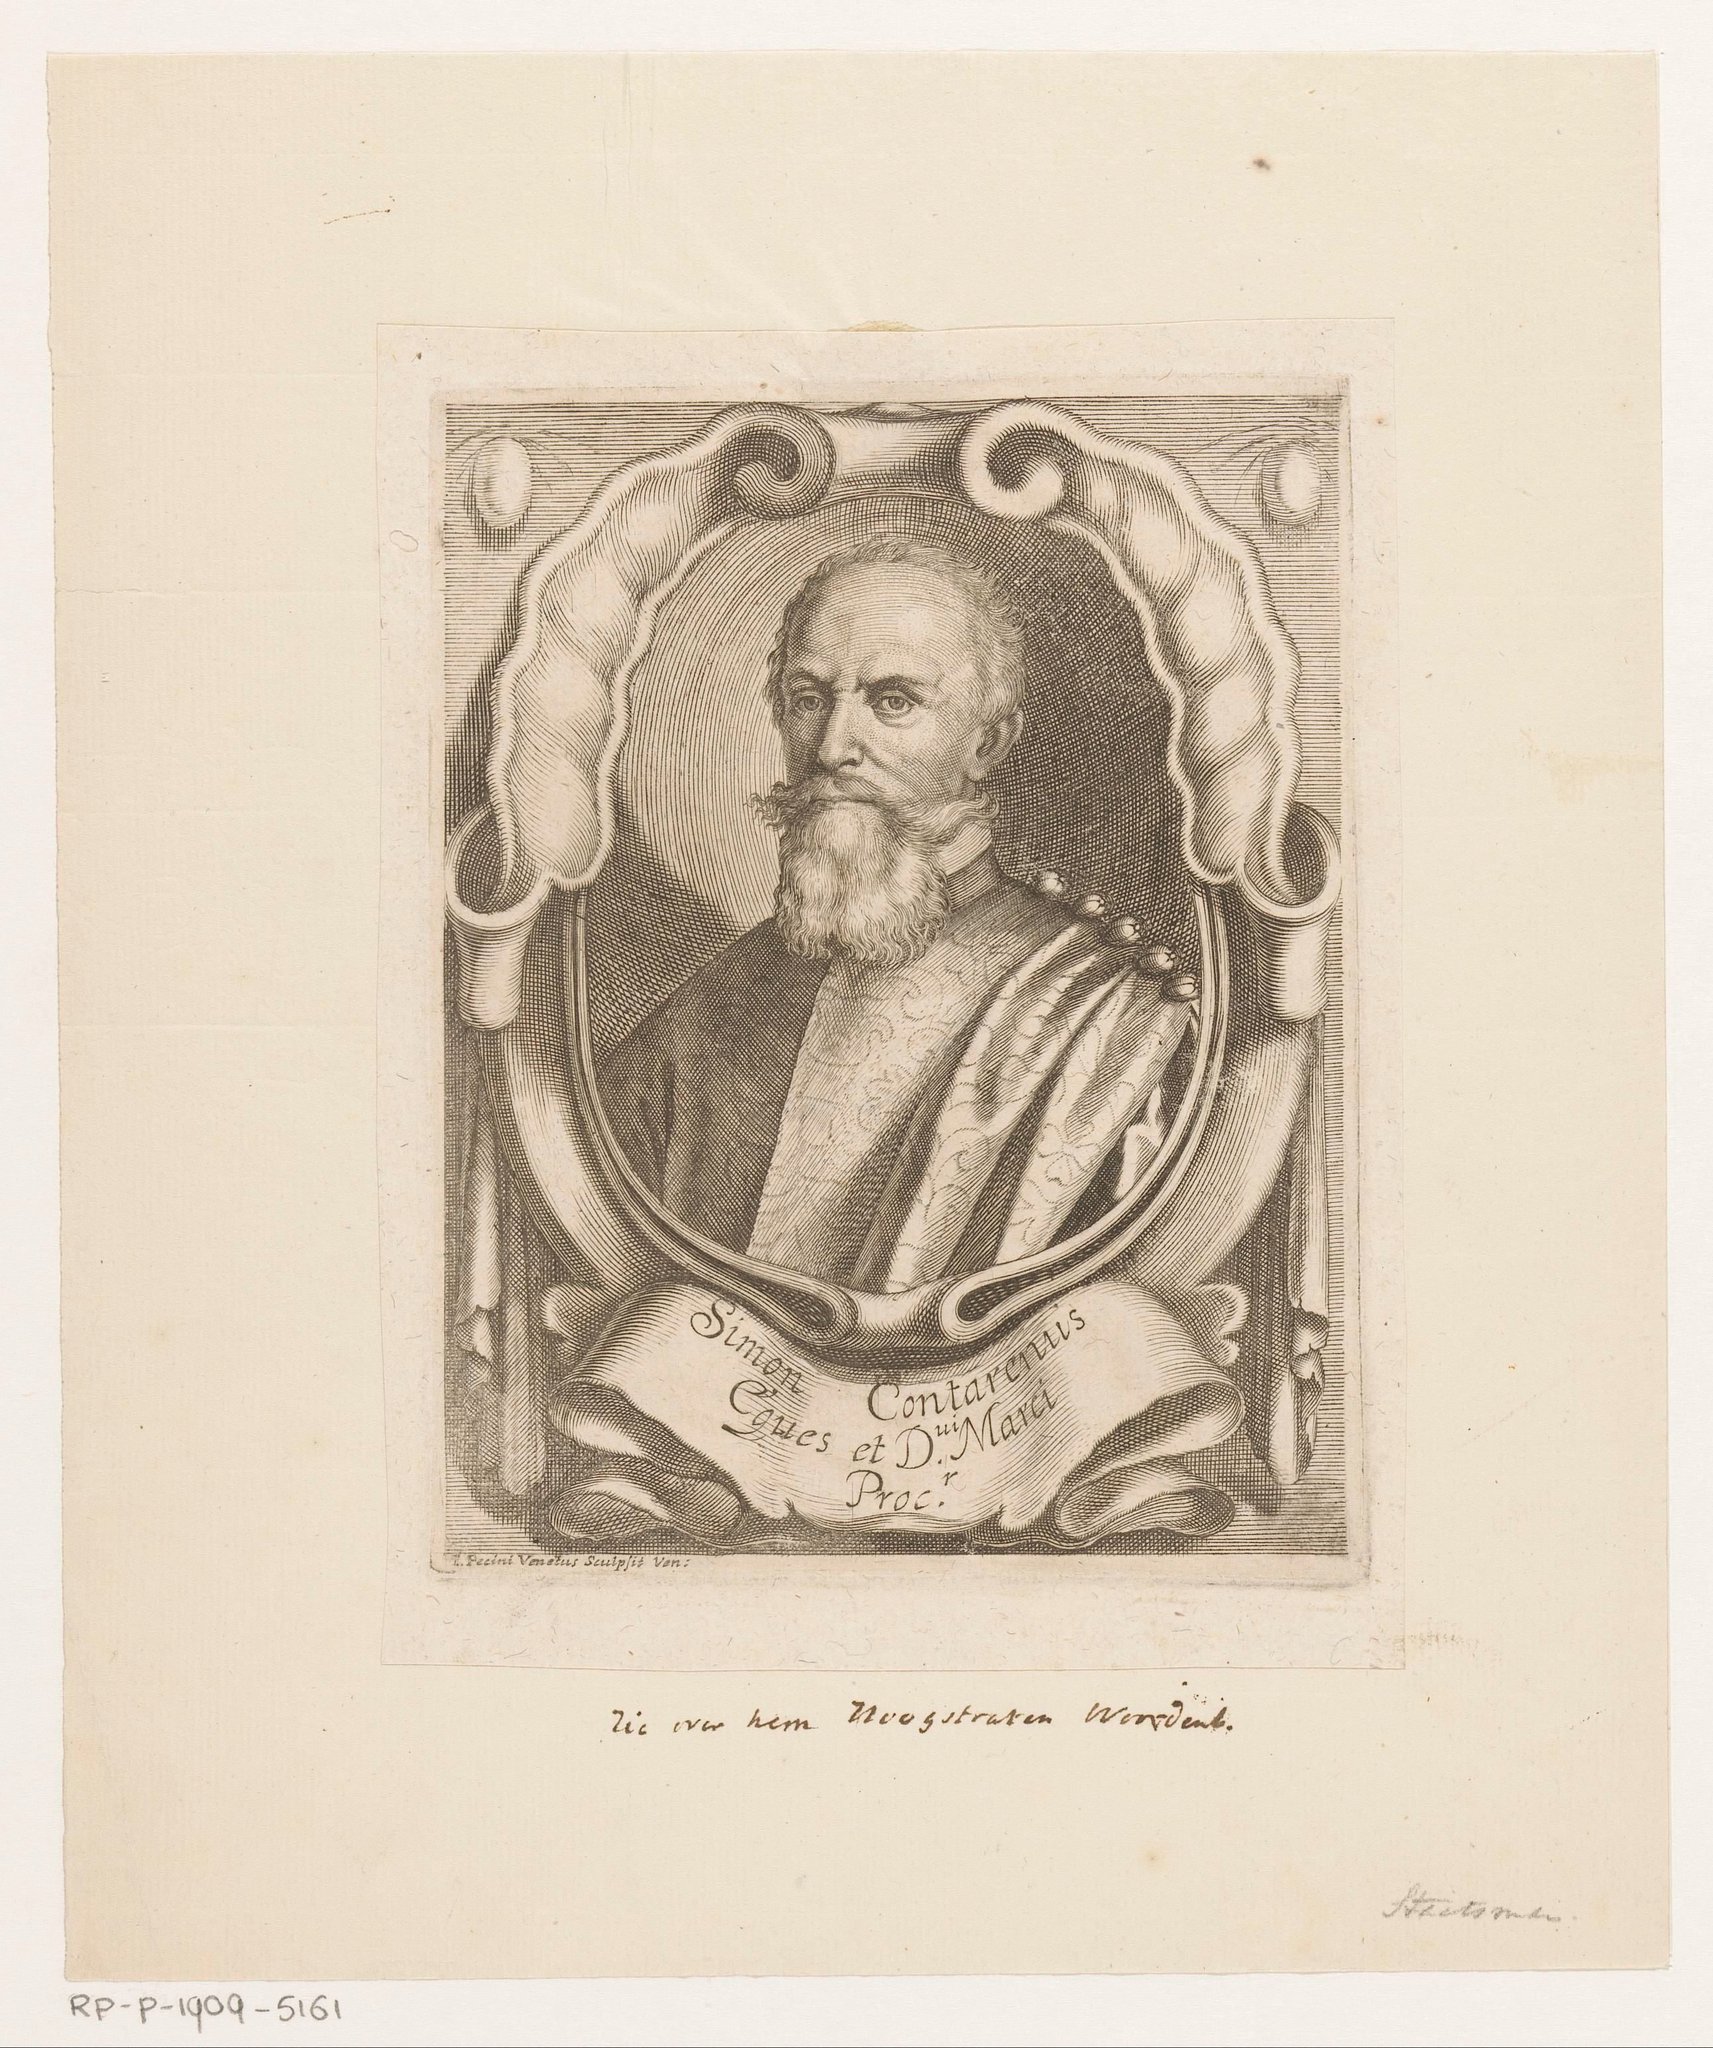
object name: print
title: Portret van diplomaat Simone Contarini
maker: giacomo piccini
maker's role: print maker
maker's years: 1617-1669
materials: paper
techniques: engraving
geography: venice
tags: simone contarini, historical persons, diplomacy, diplomat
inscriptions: collector's mark: Lugt 2228